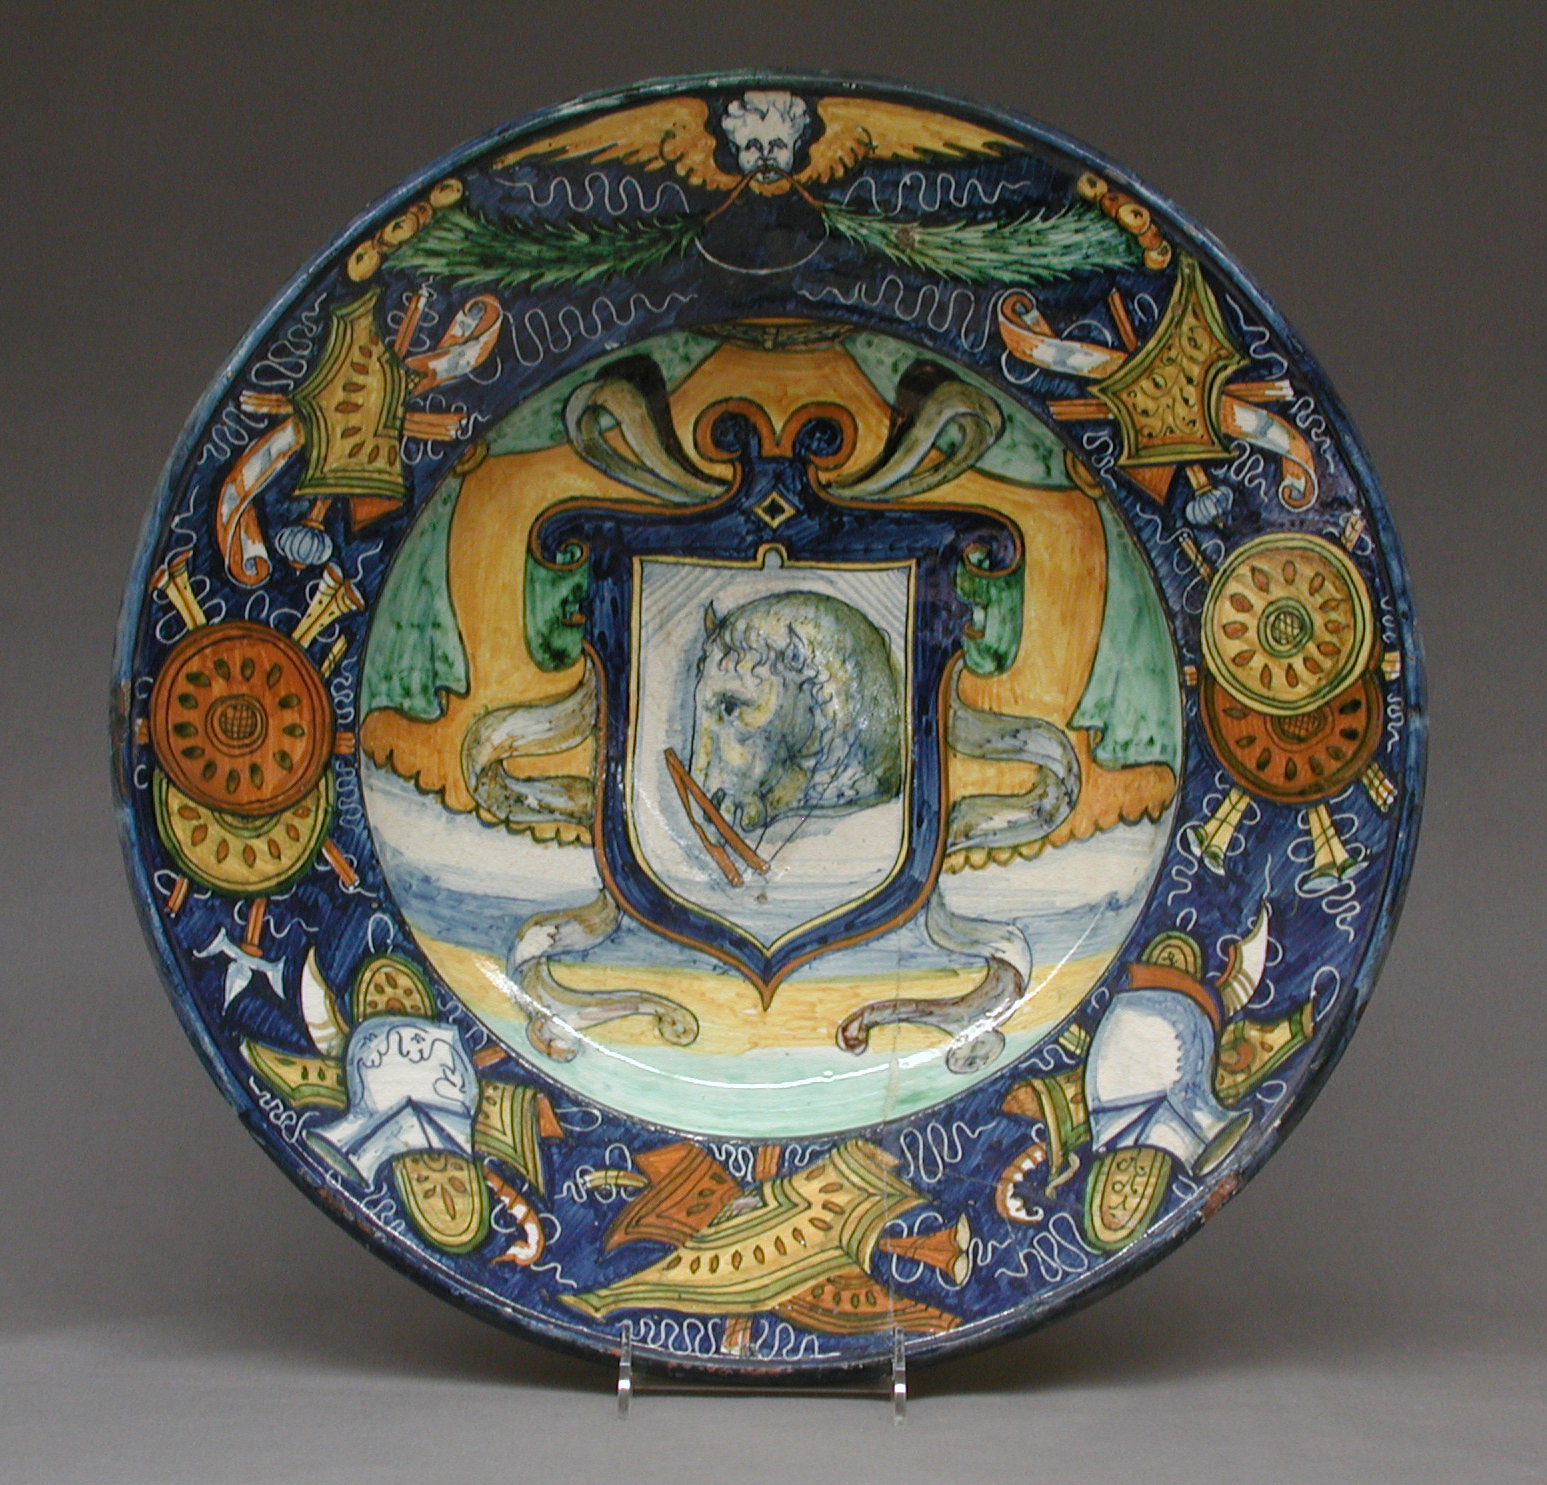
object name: dish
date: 1515-1535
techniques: maiolica, glazing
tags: horses,coat of arms